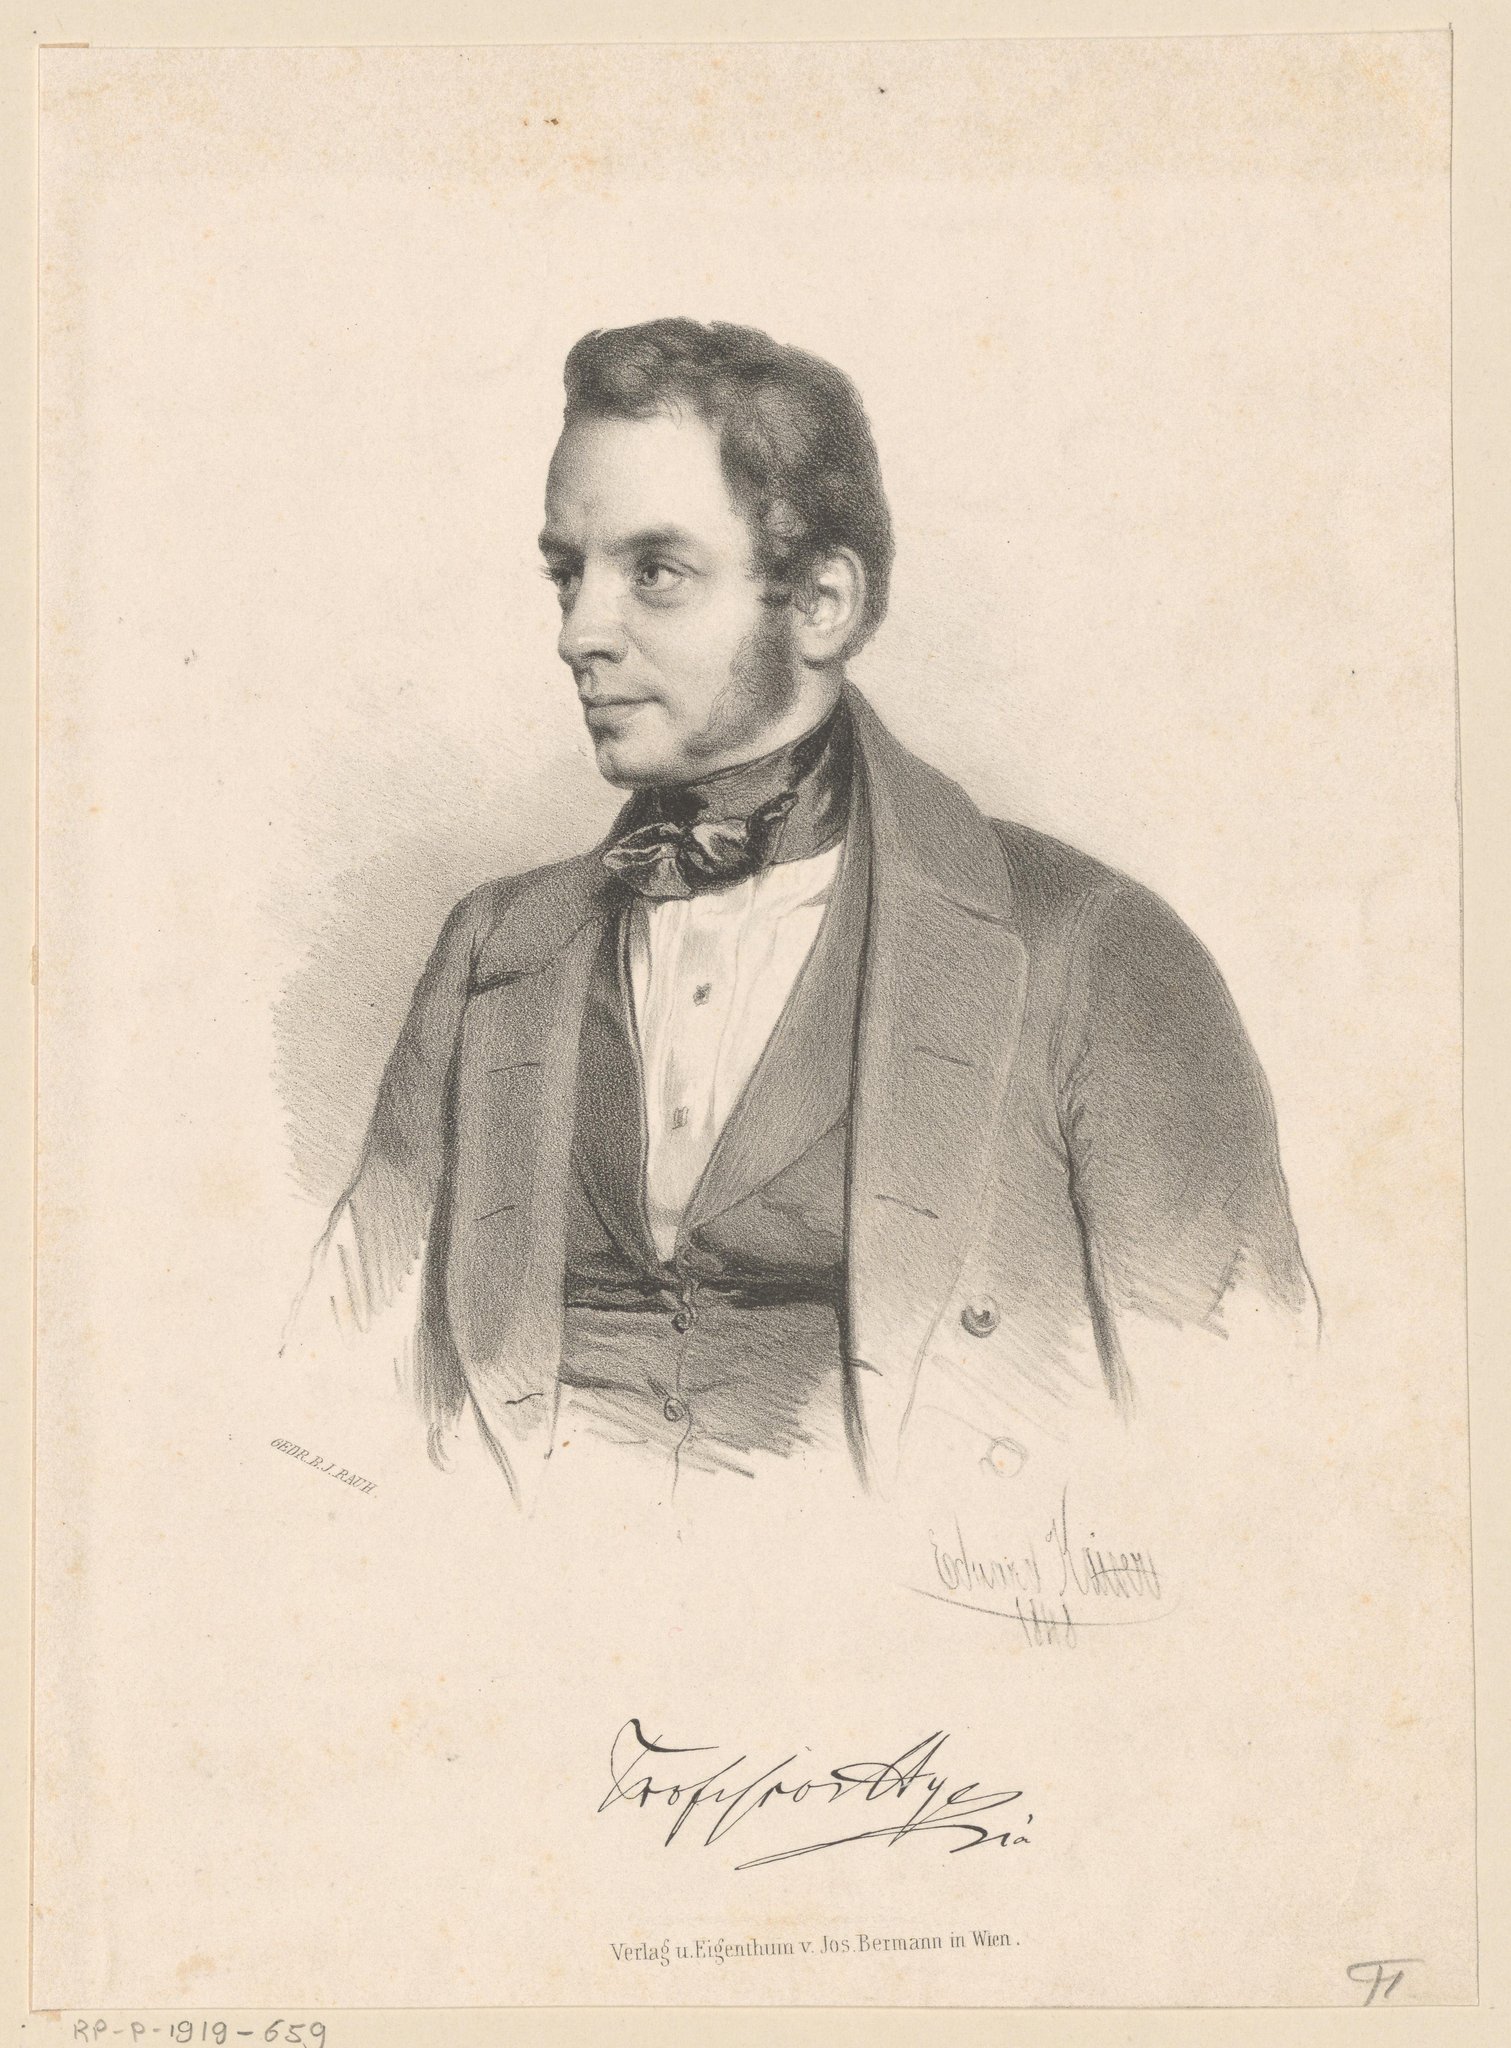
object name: print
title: Portret van Anton Hye von Glunek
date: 1848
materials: paper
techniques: lithograph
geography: vienna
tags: vienna, politician, historical persons, politician, e.g. party leader, professor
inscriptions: collector's mark: Lugt 2228